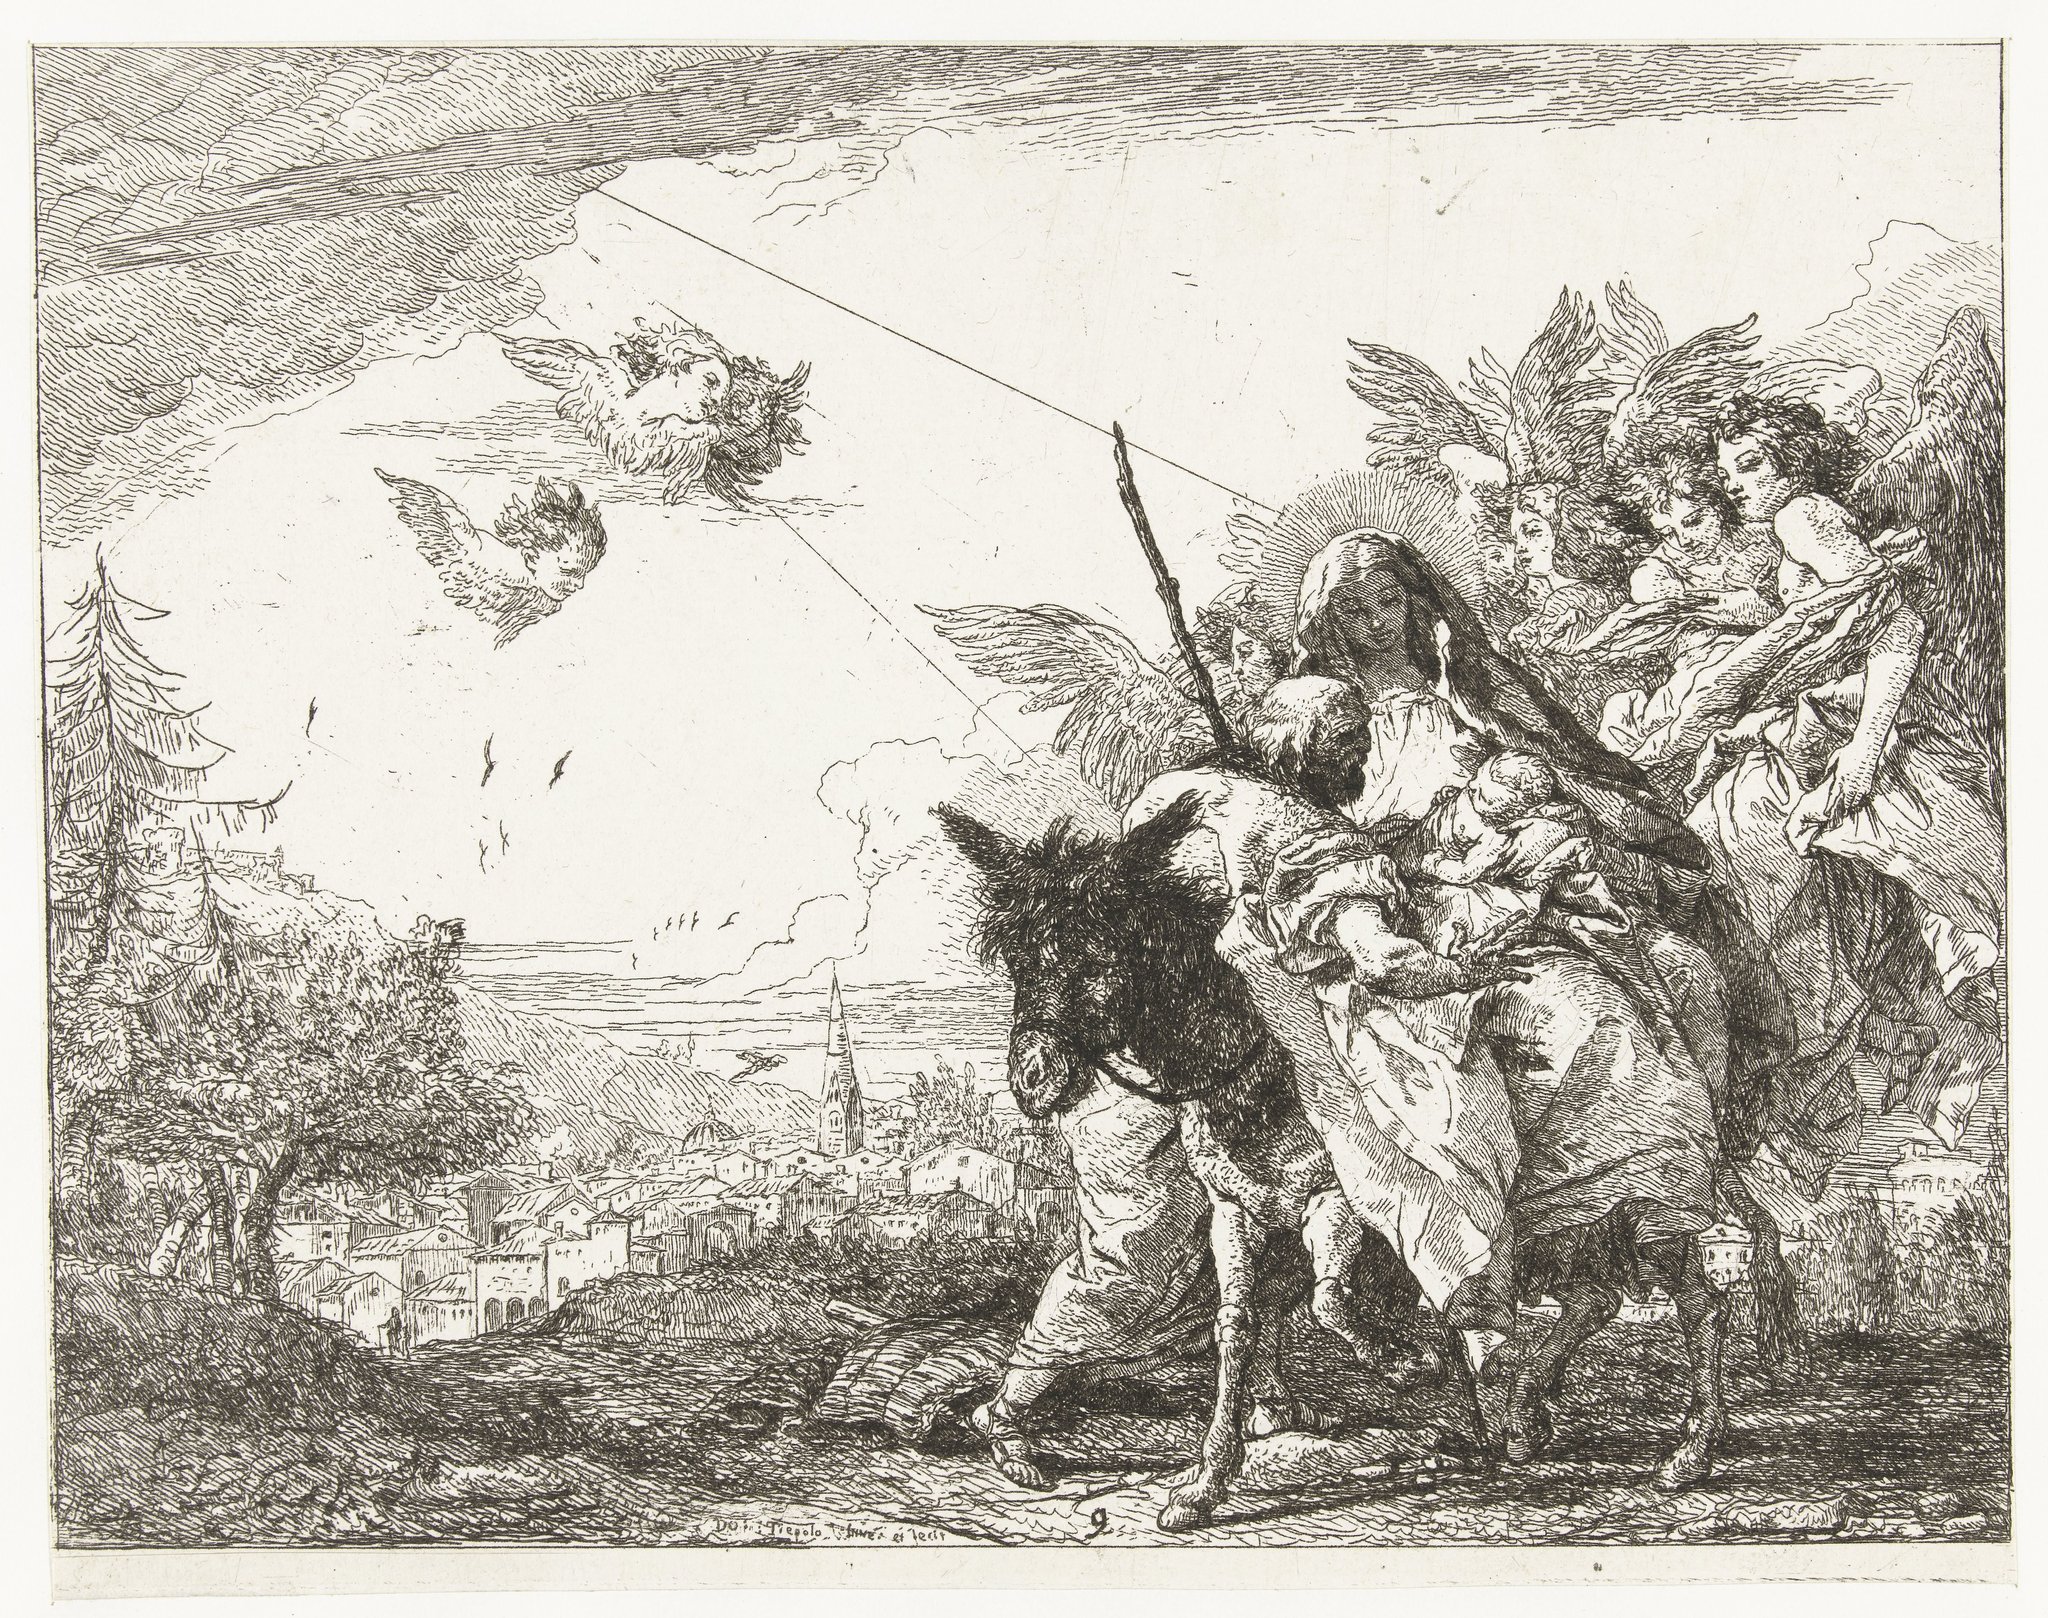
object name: print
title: Maria met Kind en Jozef in aanbidding omringd door engelen tijdens vlucht naar Egypte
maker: giovanni domenico tiepolo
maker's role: draughtsman, print maker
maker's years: 1727-1804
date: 1750-1753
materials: paper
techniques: etching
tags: flight into egypt and miracles during the journey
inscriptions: collector's mark: Lugt 2760, collector's mark: Lugt 2228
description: Prent uit serie van zevenentwintig prenten met de Vlucht naar Egypte.